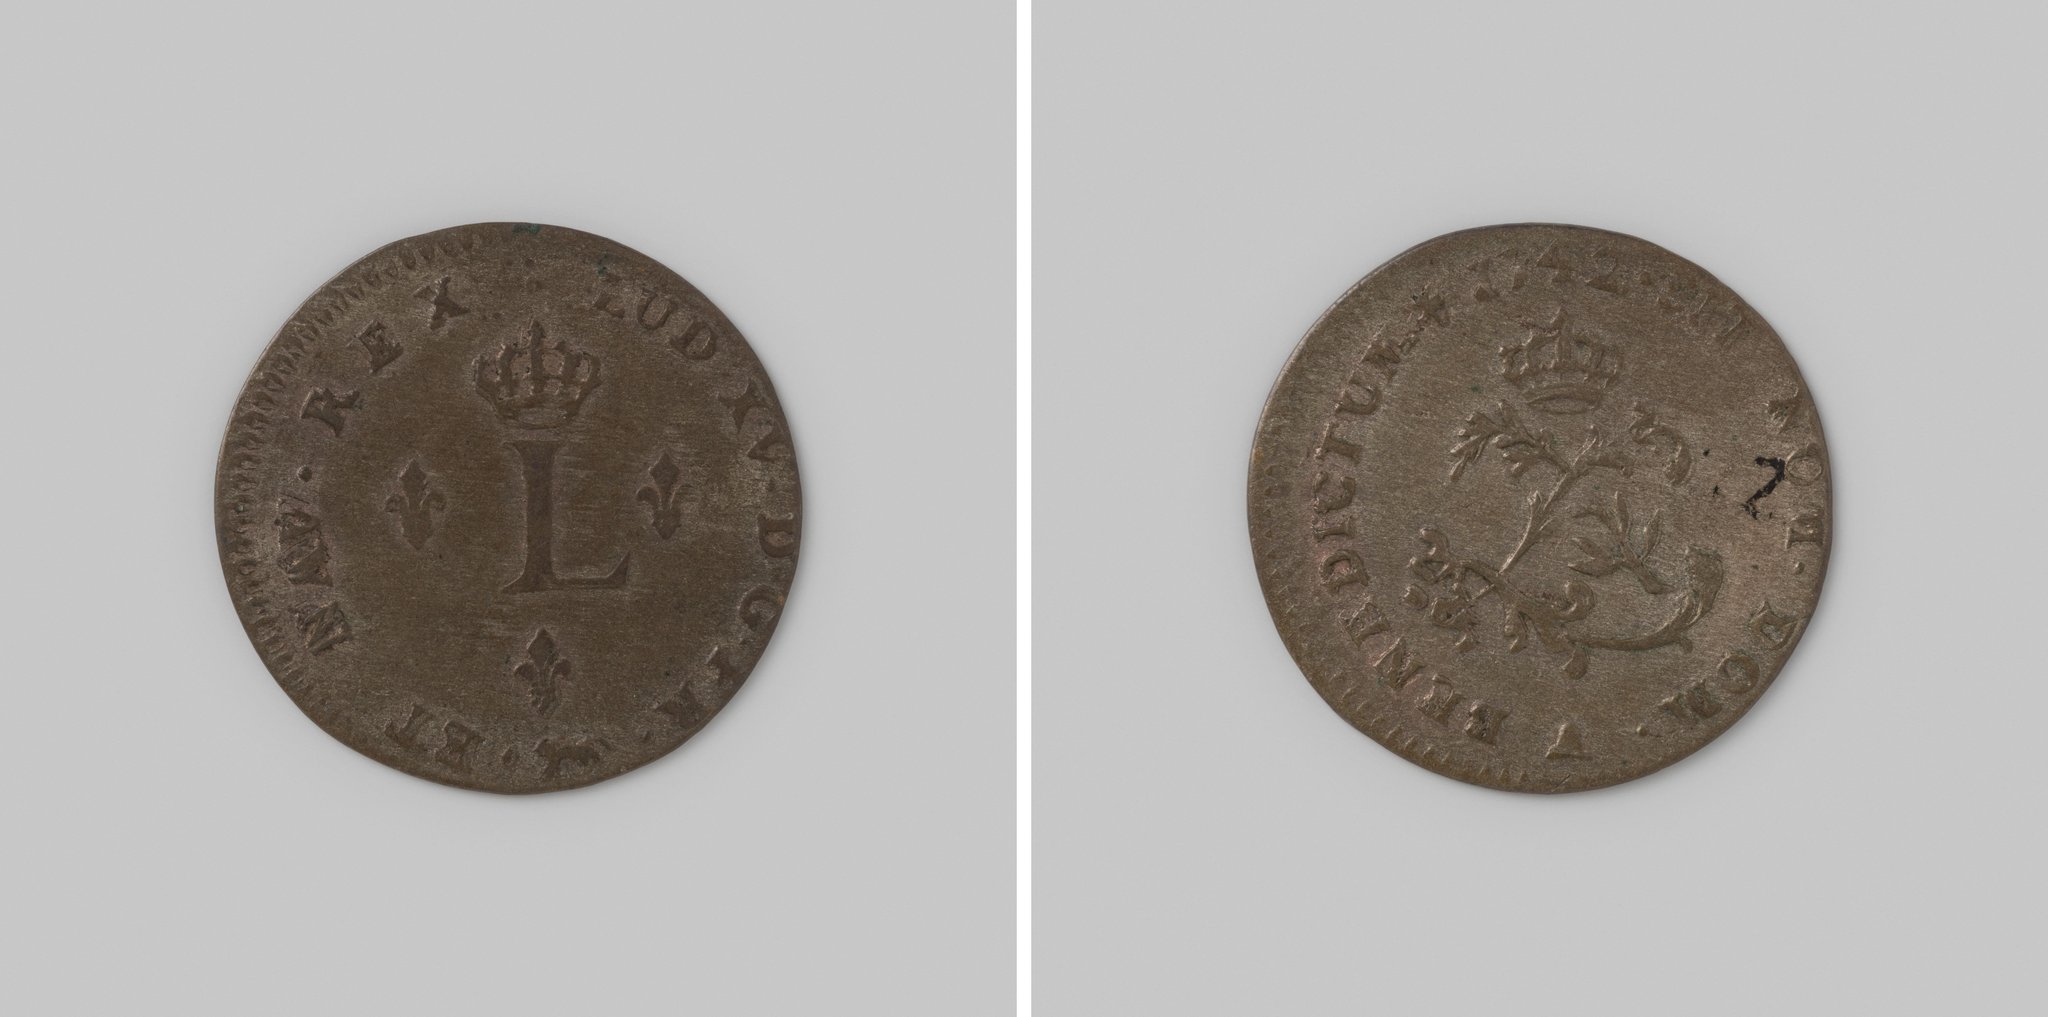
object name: coin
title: Frankrijk, ook voor Frans West-Indië, koning Lodewijk XV, 2 sols, 1742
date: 1742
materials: silver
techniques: striking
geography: paris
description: Zilveren munt. Voorzijde: tussen drie lelies gekroond monogram van de koning. Keerzijde: gekroond versierd monogram van de koning, waaronder letter A [=Parijs]. Bovenaan jaartal. Gladde rand.